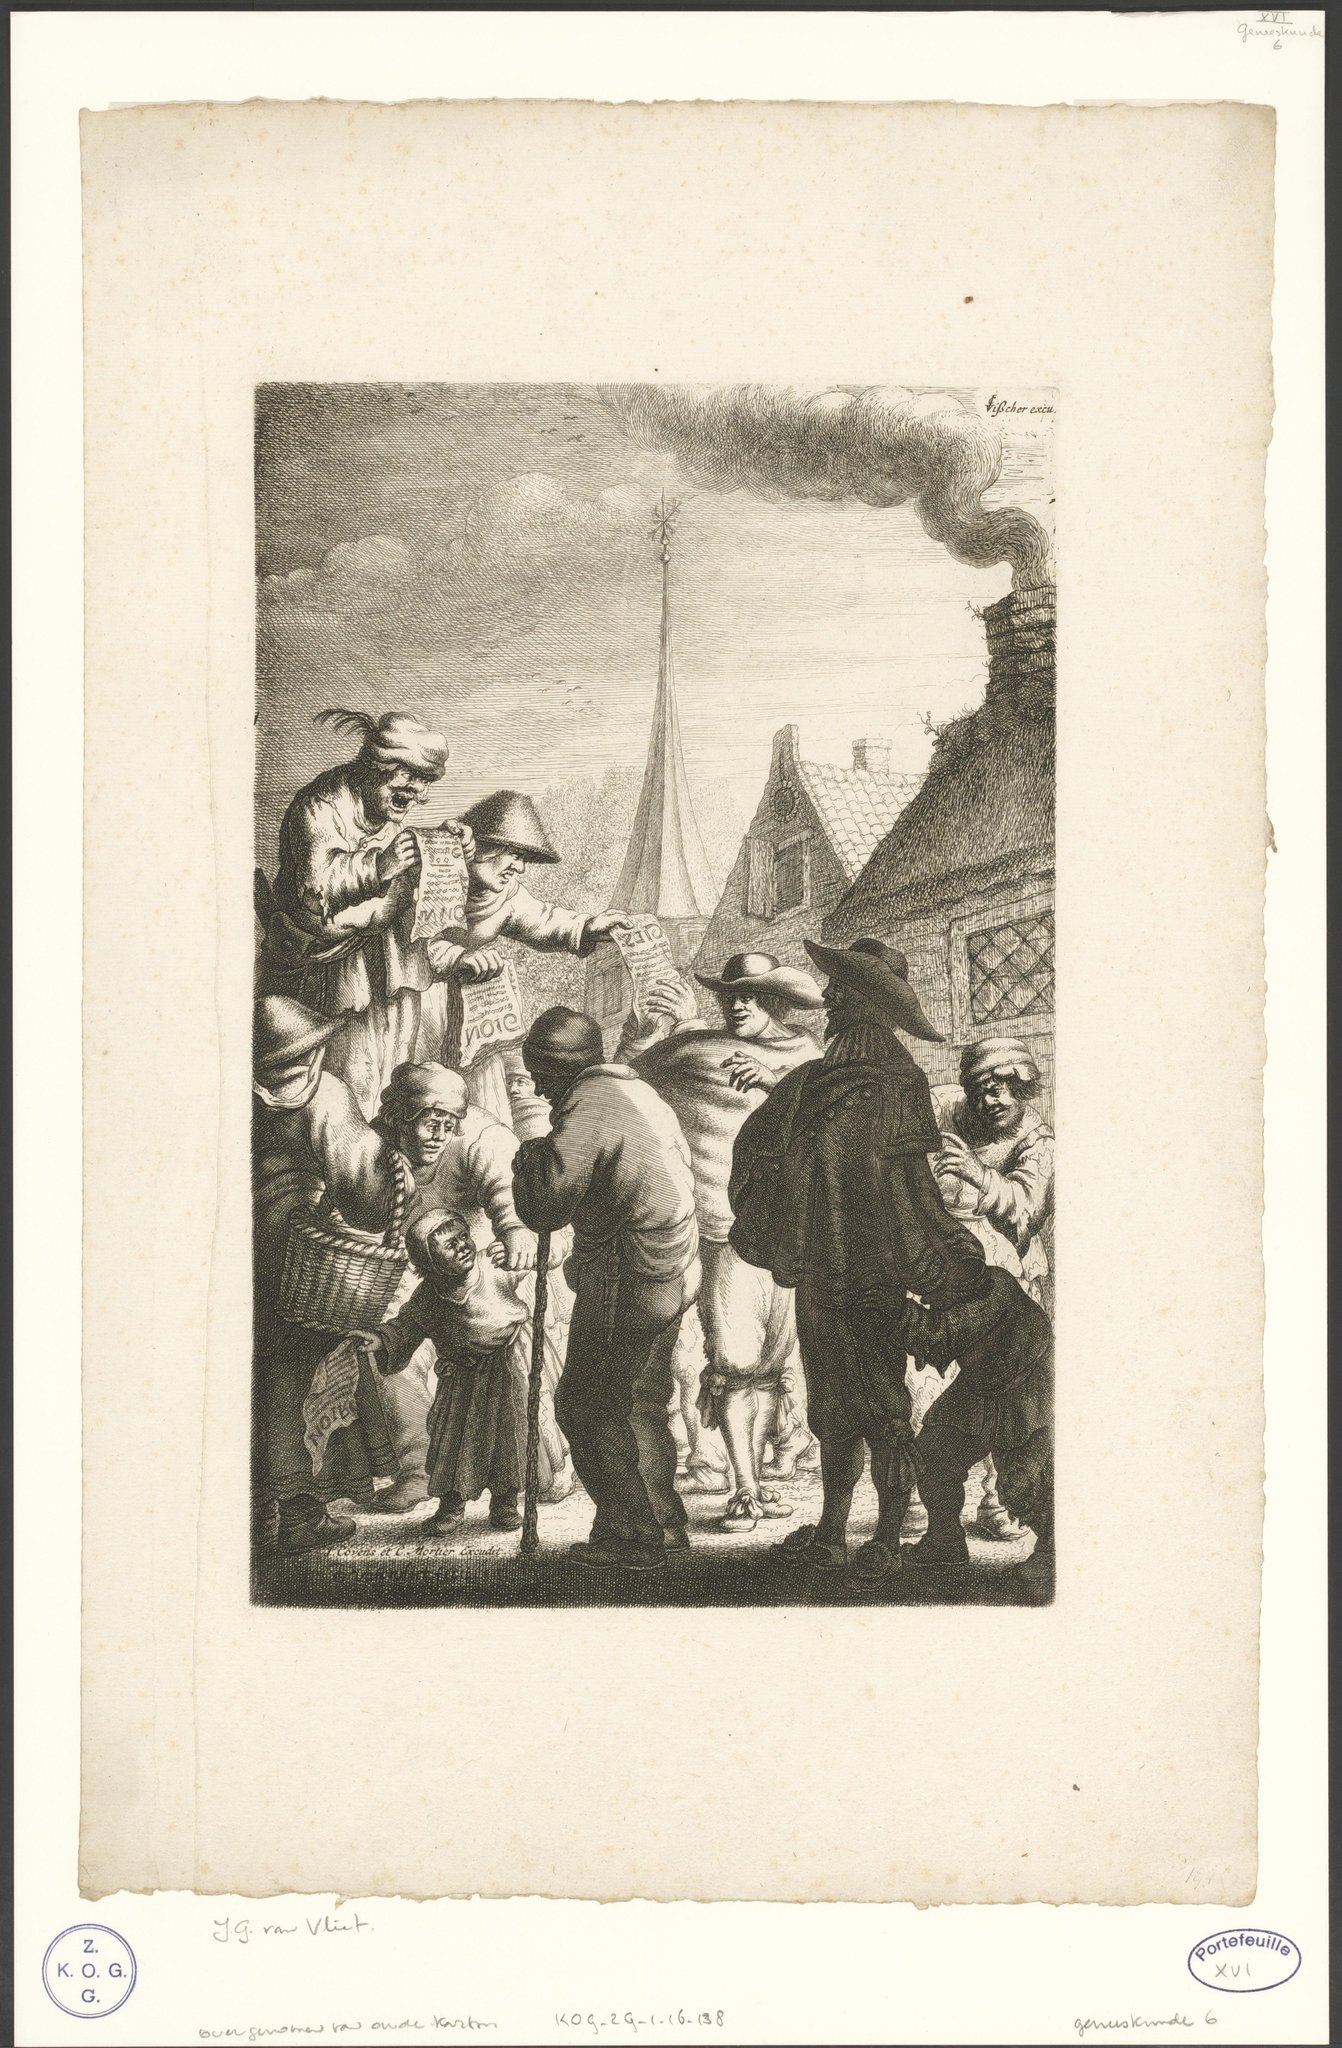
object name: print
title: Liedtekstenverkoper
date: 1632-1634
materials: paper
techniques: engraving, etching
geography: amsterdam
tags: ballad singer, ballad seller - cc - out of doors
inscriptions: collector's mark, collector's mark: Lugt 1641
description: Dorpelingen drommen samen bij een verkoper van liedteksten op losse vellen, staand op een verhoging. Rechts op de voorgrond is een zakkenroller aan het werk. Onderwerpsrubrieken binnen de Atlas Zeden en Gewoonten: Onderwijs en Wetenschappen: Geneeskunde (het onderwerp van de prent ten onrechte geïnterpreteerd als een kwakzalver, en daarom ingedeeld op dit onderwerp).